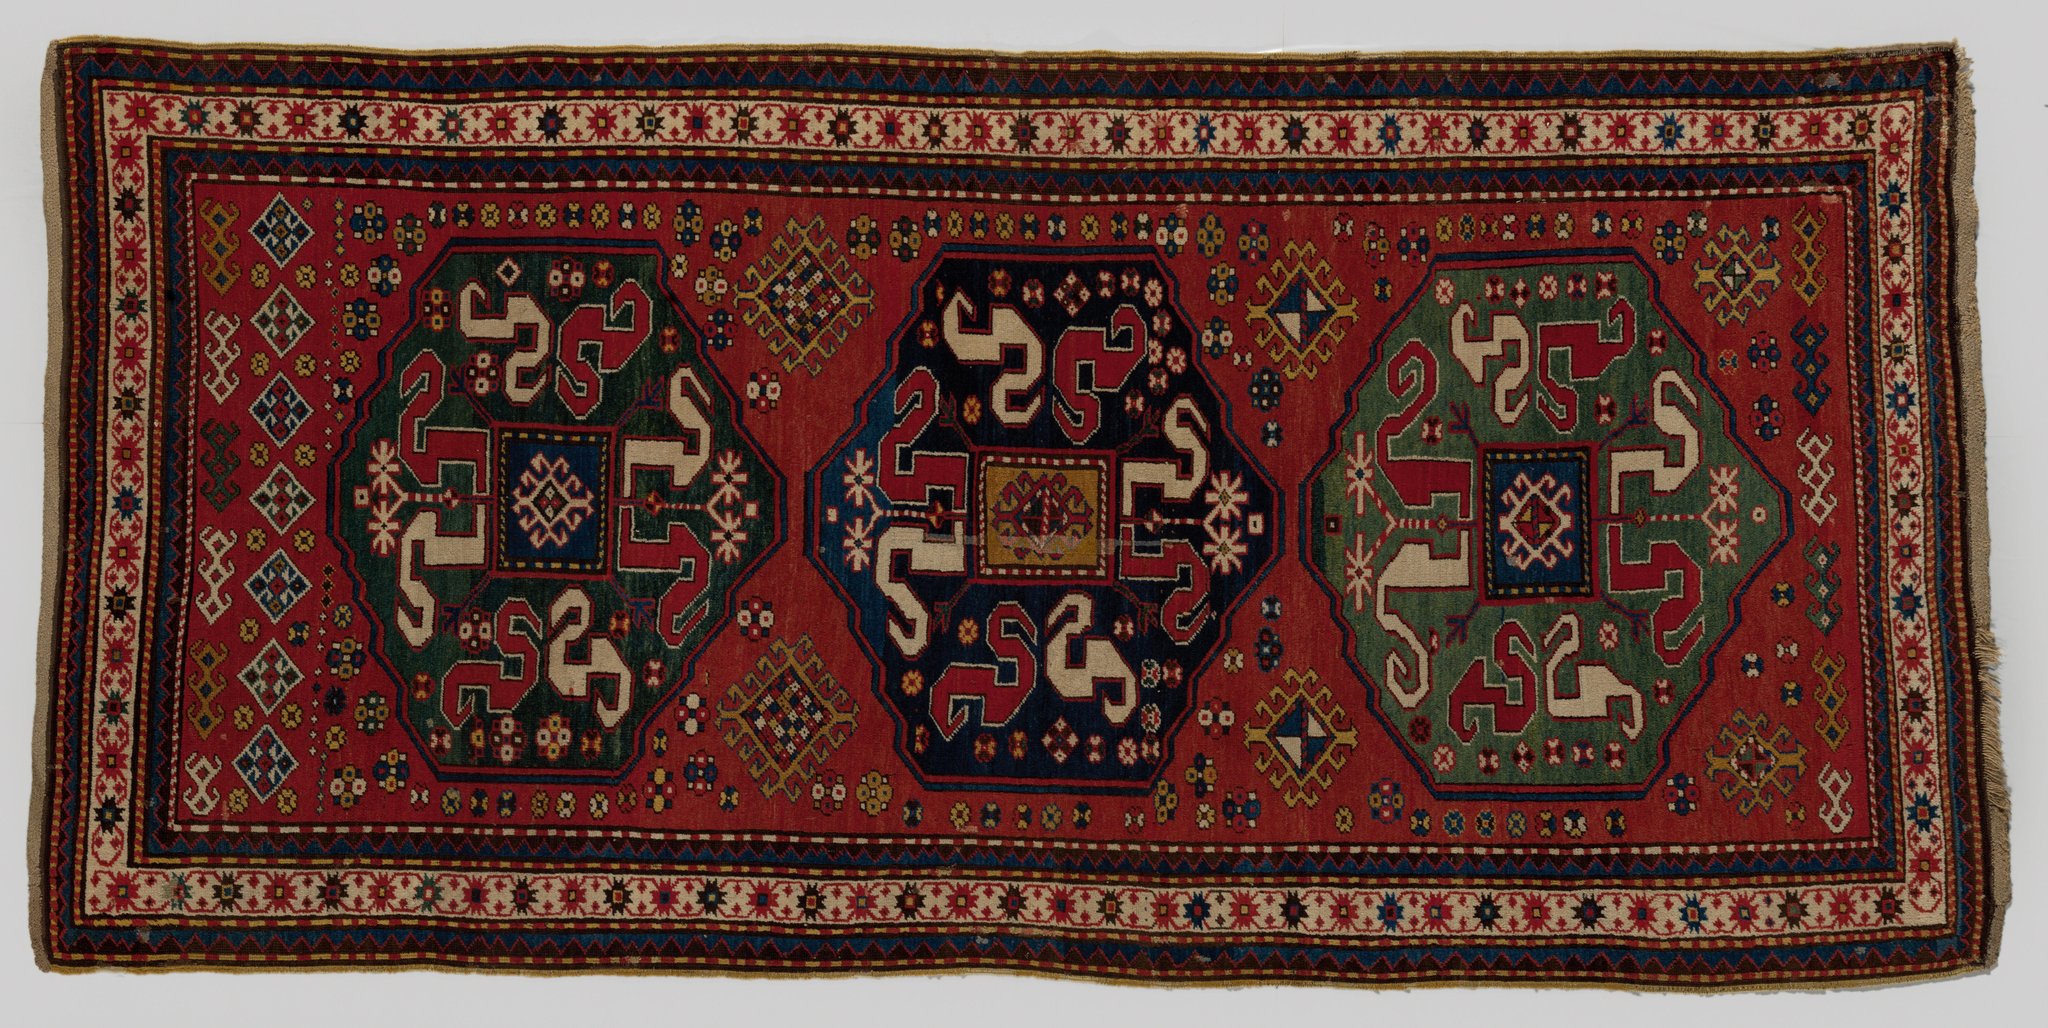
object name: oriental rug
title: Oosters tapijt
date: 1800-1825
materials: wool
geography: kazakhstan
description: Oosters tapijt, medaillonkleed. Op het middenveld staan drie zeshoekige medaillons, tegen een rood fond. Hierin een vulling van wolkenbanden, ruiten en rozetten. De middelste rand is versierd met stermotieven.